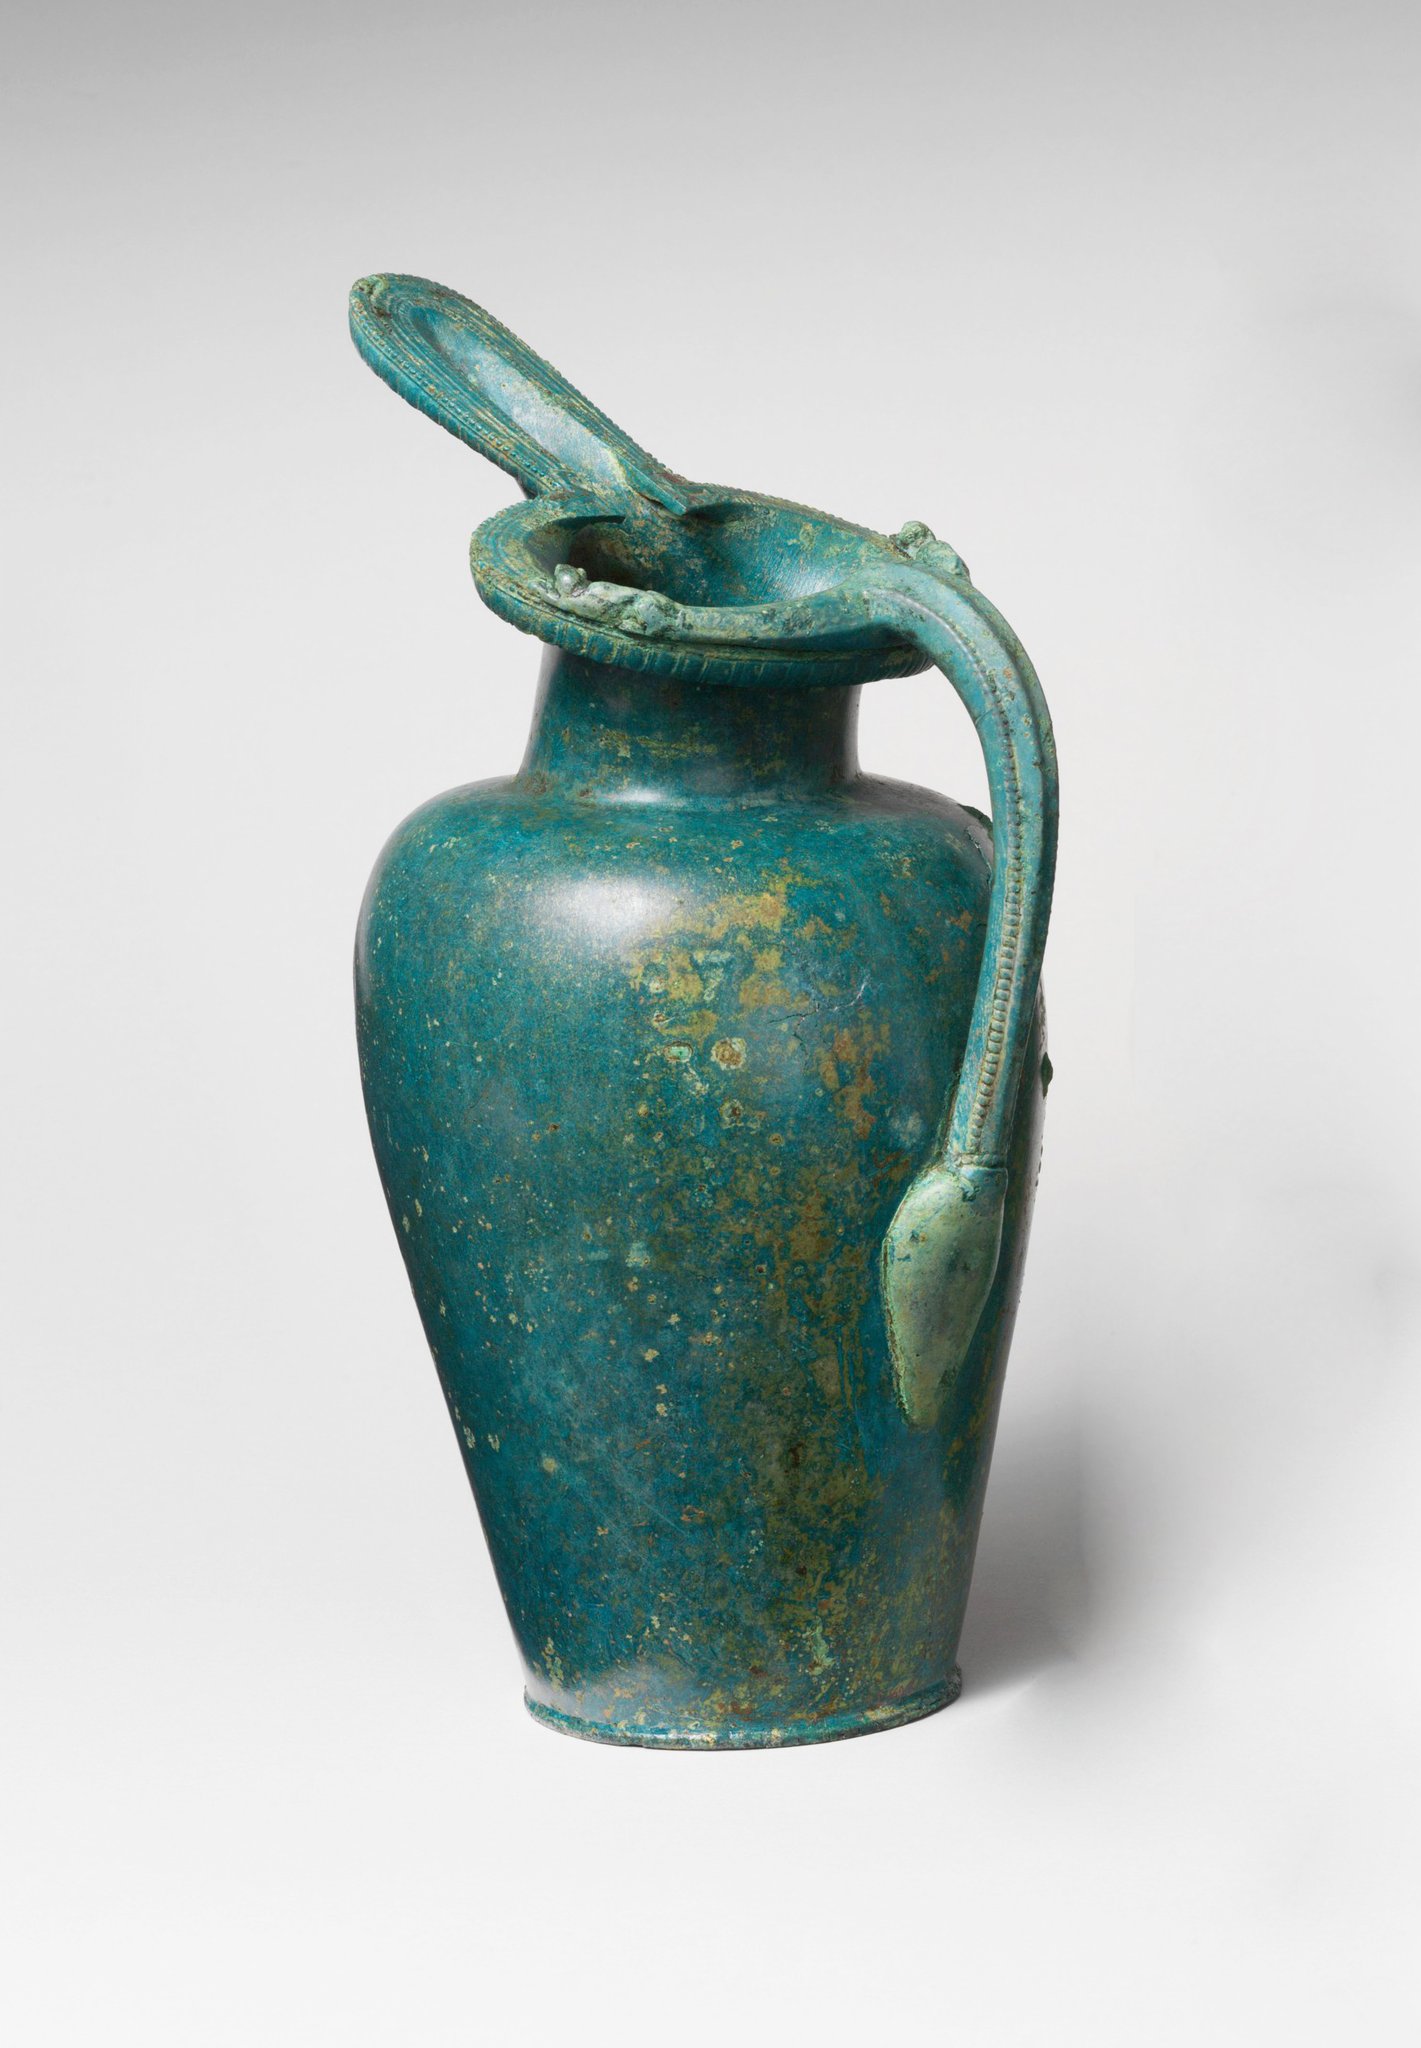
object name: jug with handle of lion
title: Bronze oinochoe (jug)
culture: etruscan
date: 500-401 BCE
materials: bronze